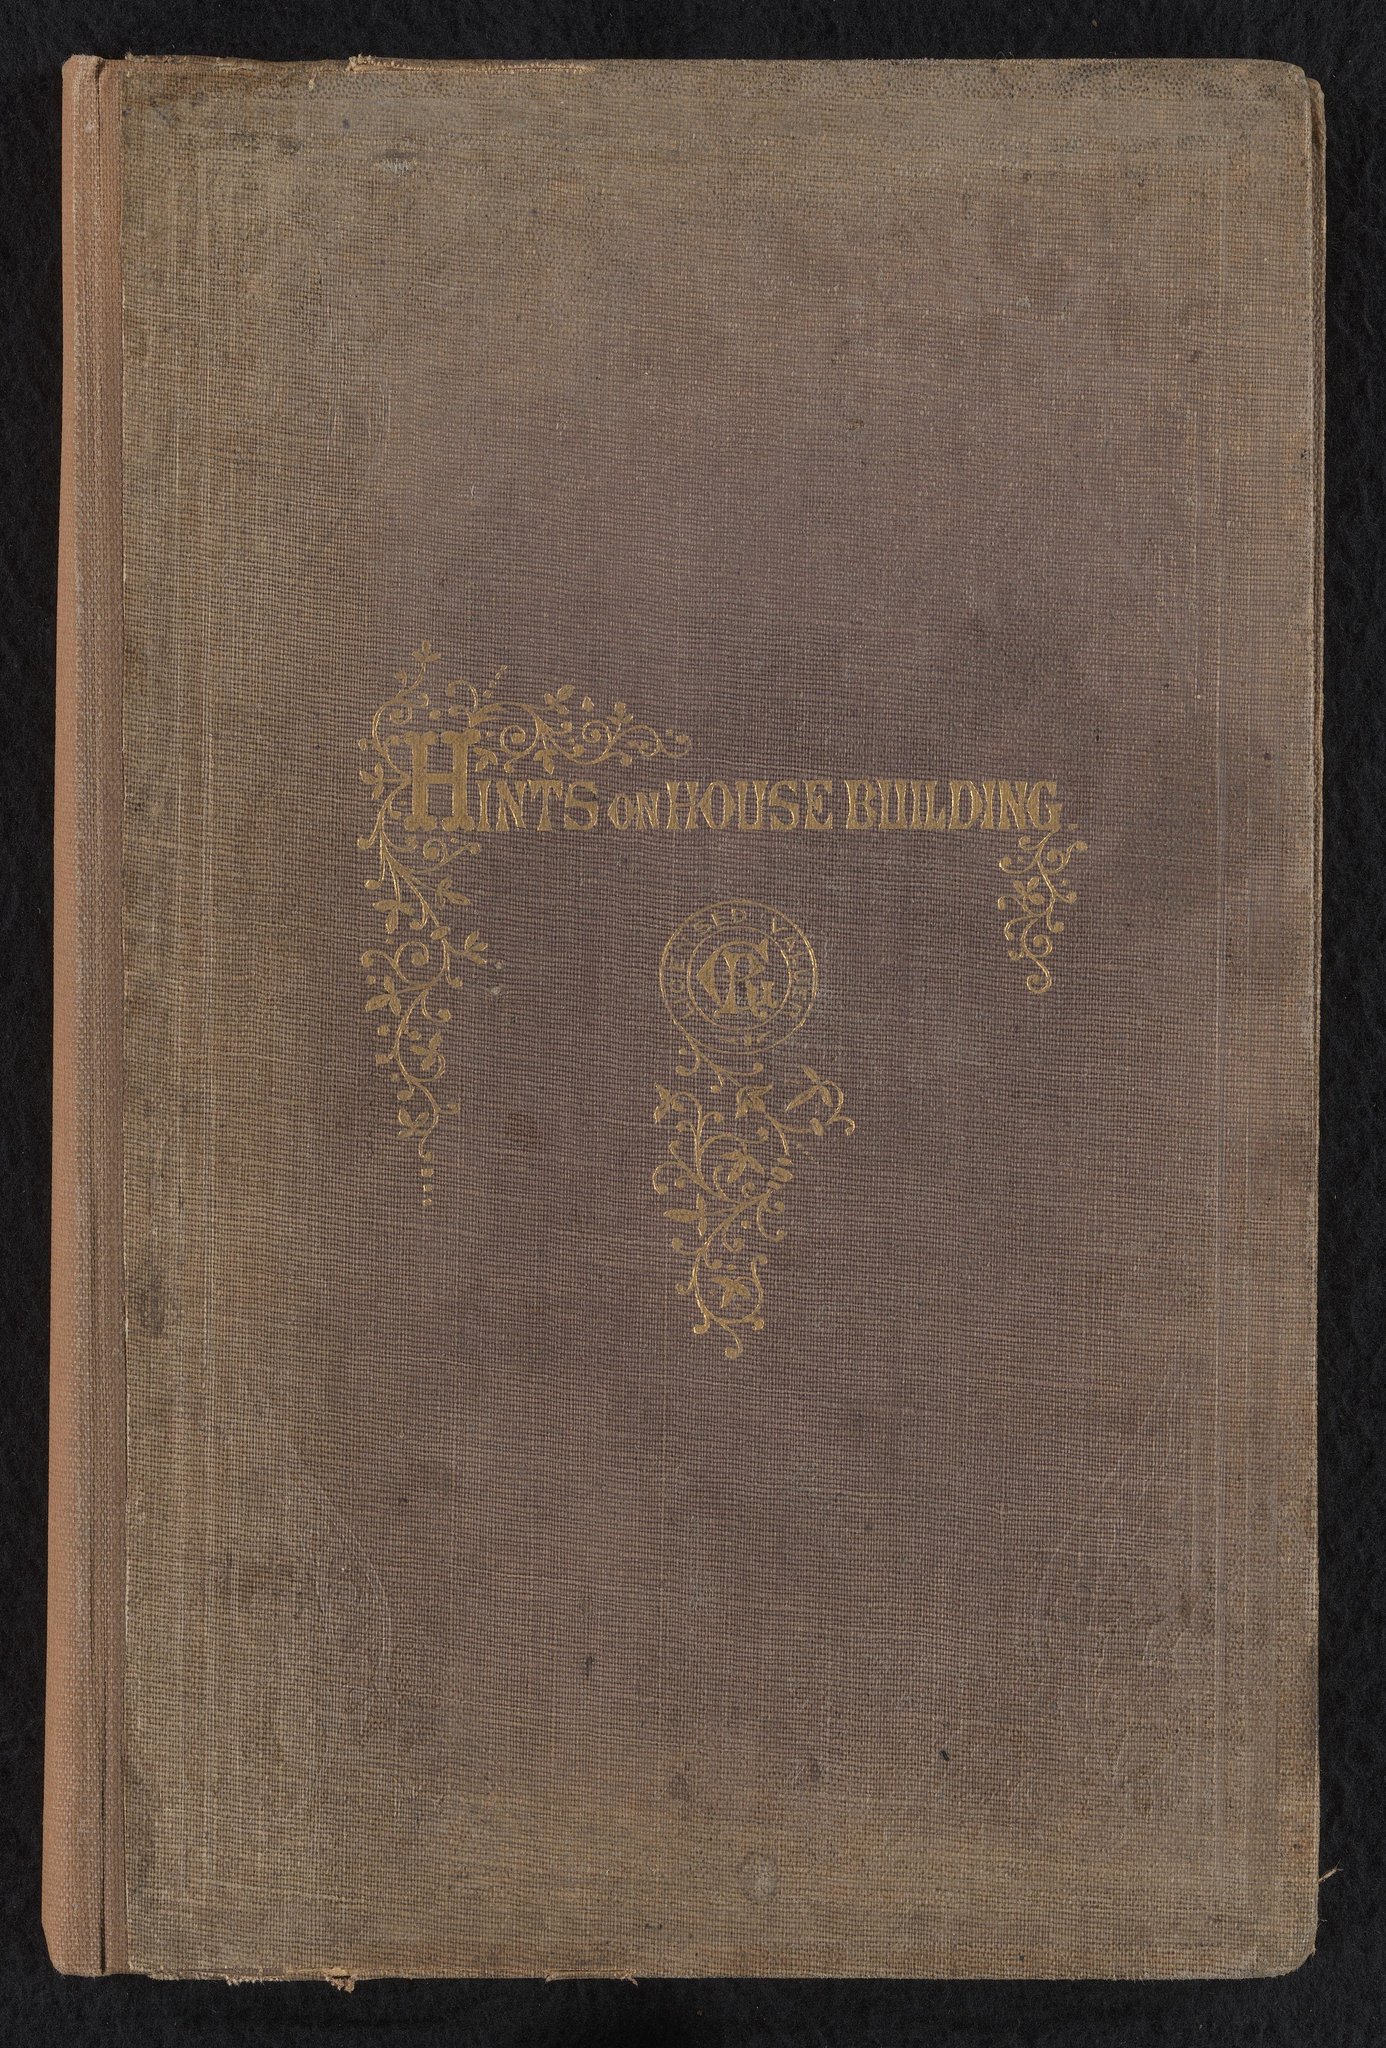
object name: book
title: Hints on House Building to proprietors, occupiers of houses, and artisan builders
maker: j. r. gummow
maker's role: architect, auteur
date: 1874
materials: cardboard, linen, paper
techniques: lithograph, printing, woodburytype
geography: wrexham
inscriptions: date: ‘MAY/ 2010’